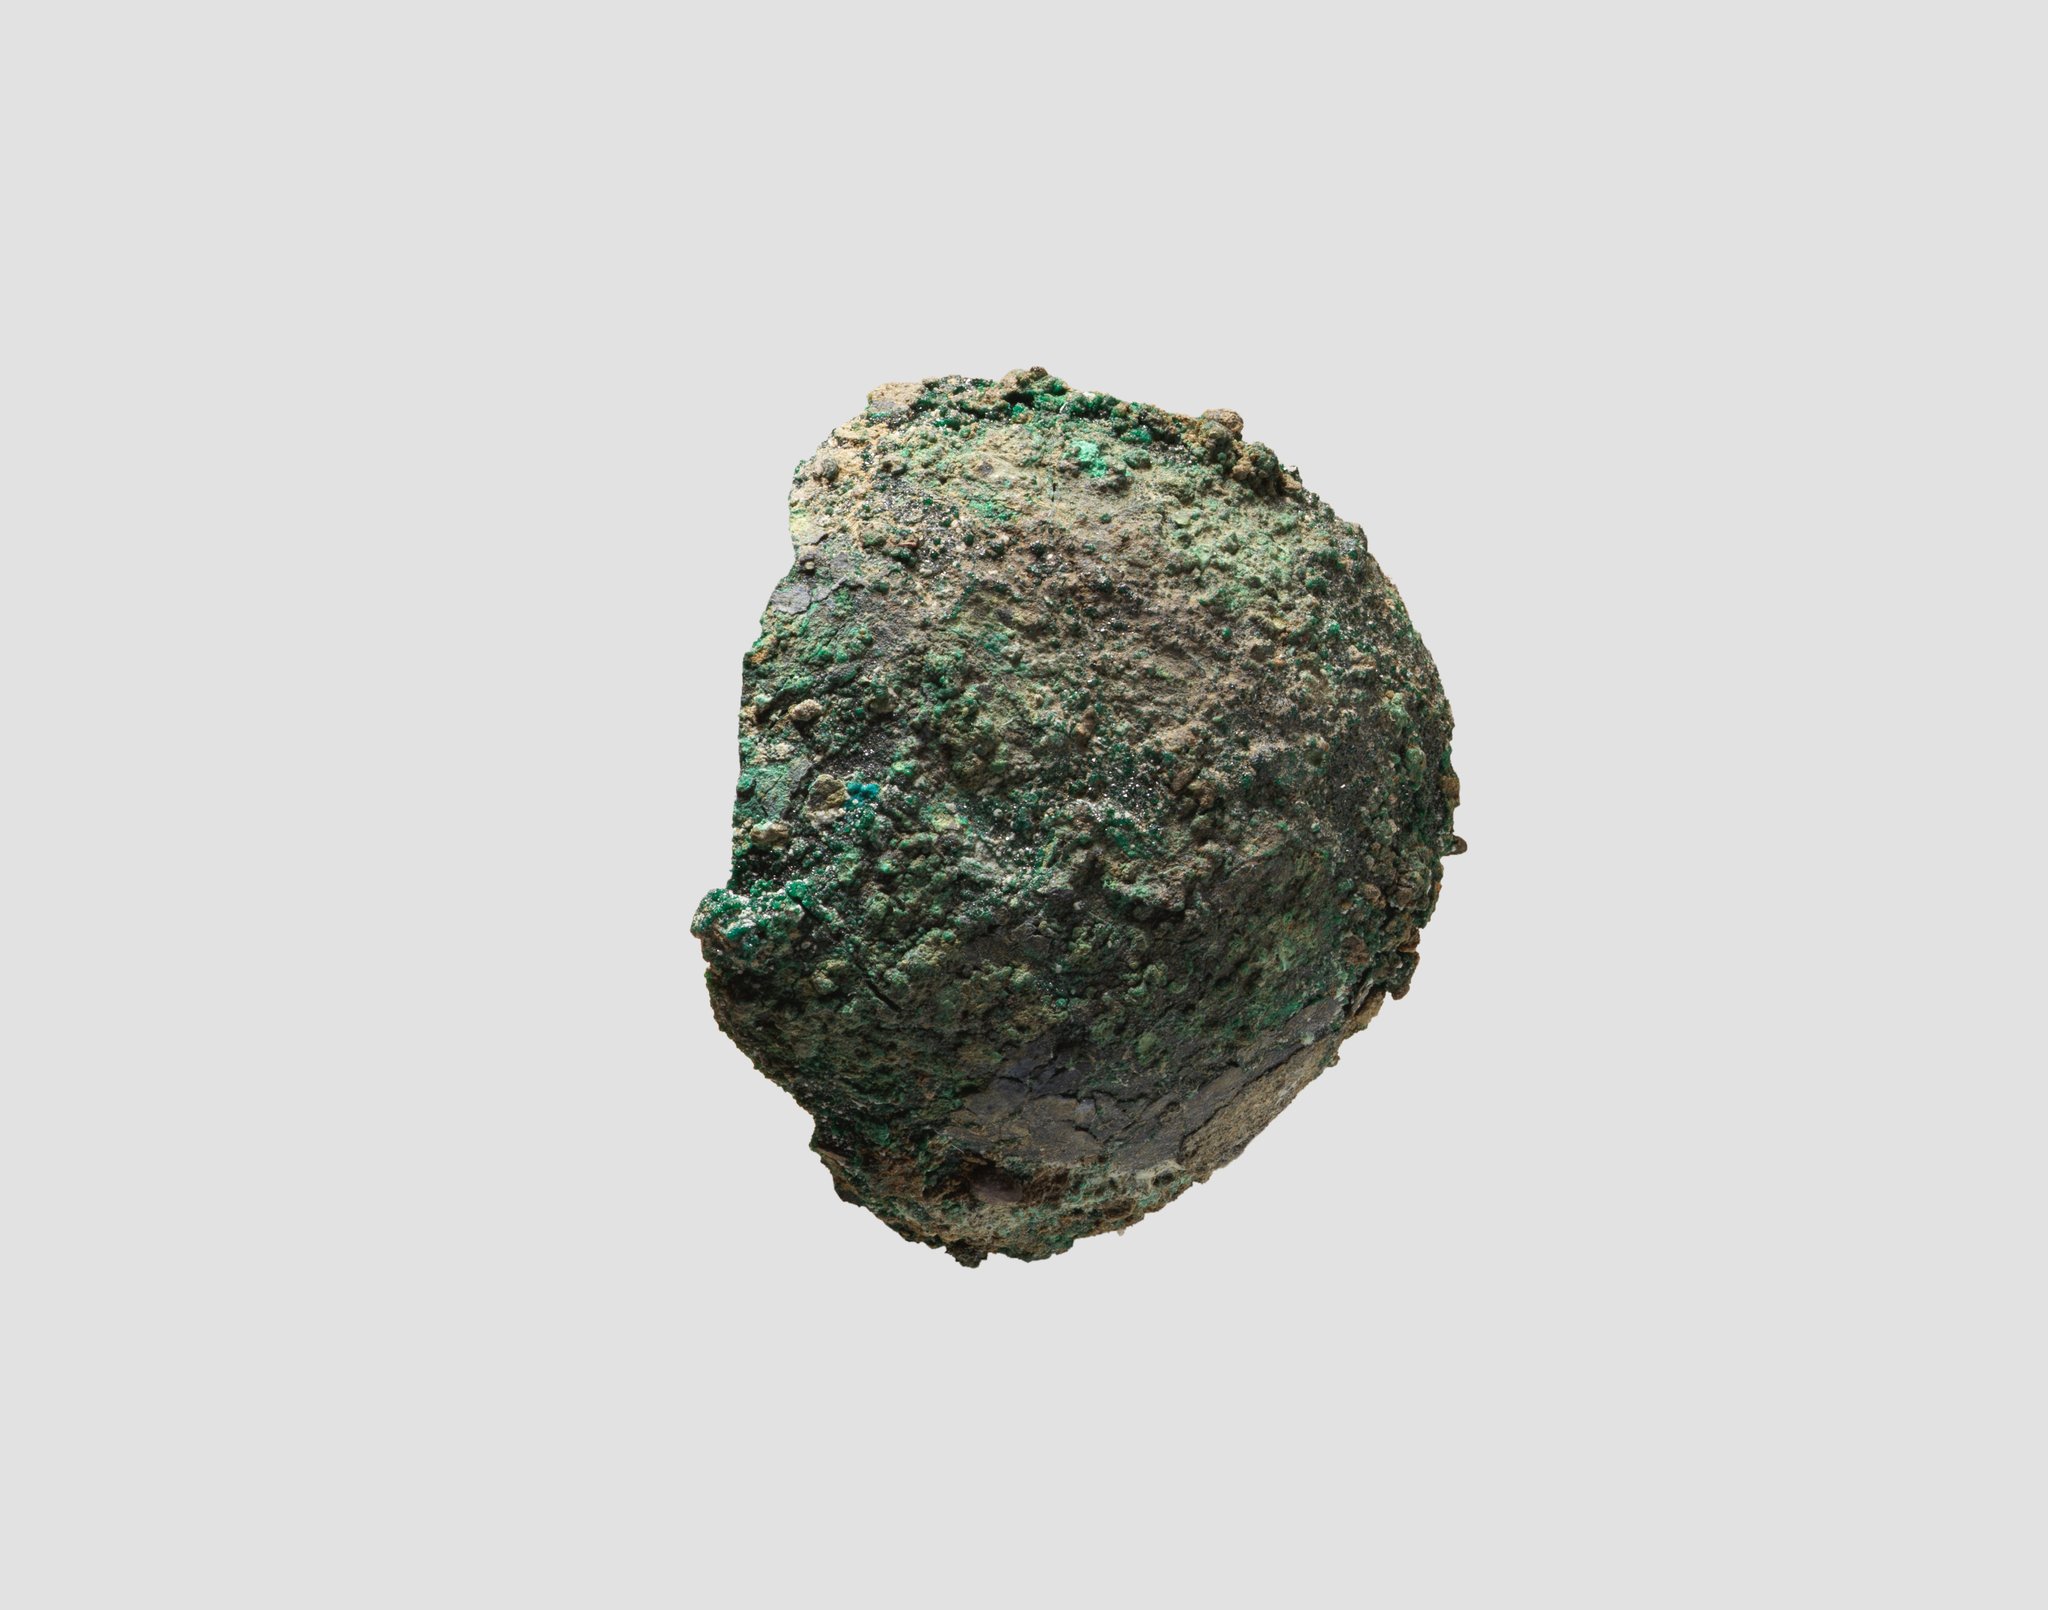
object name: stud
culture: iranian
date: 900-801 BCE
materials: bronze, copper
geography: iran